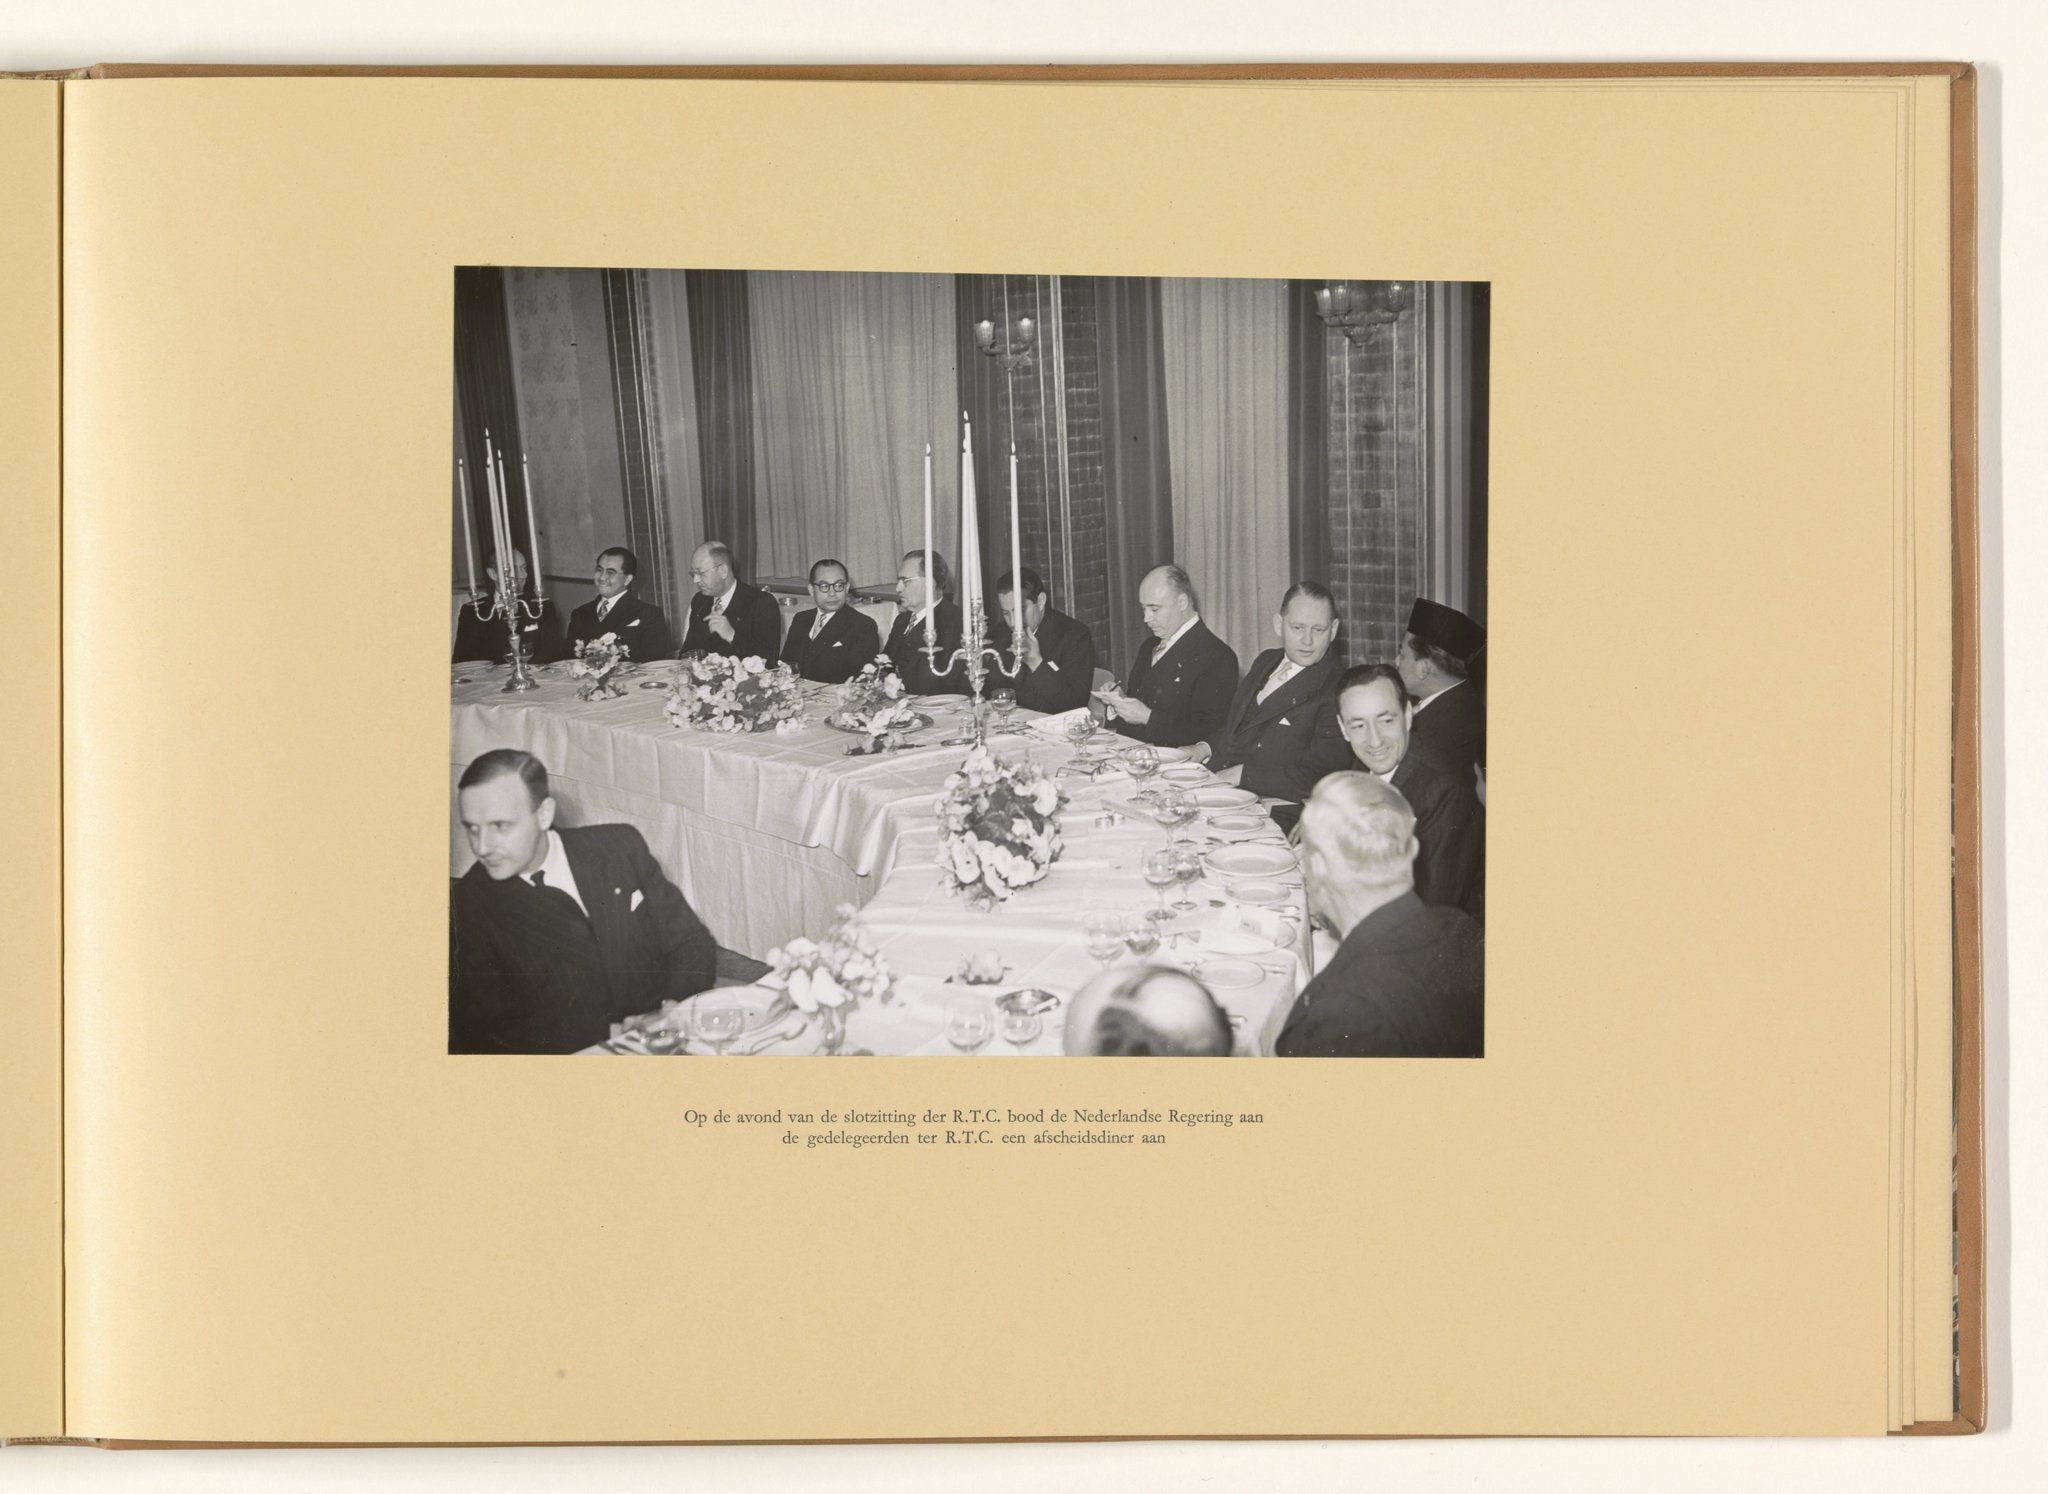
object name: photograph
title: Op de avond van de slotzitting der R.T.C. bood de Nederlandse Regering aan de gedelegeerden der R.T.C. een afscheidsdiner aan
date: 1949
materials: paper, photographic support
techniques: gelatin silver print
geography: the hague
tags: mohammad hatta, utrecht, willem drees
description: Afscheidsdiner aan de gedelegeerden op de slotdag van de rondetafelconferentie op 2 november 1949. Links minister Van Maarseveen, premier Hatta, premier Drees en sultan Hamid II. Foto in het fotoalbum met 37 foto's van de rondetafelconferentie gehouden tussen 23 augustus en 2 november in Den Haag in 1949 tussen vertegenwoordigers van Nederland, de Republiek Indonesië en de Bijeenkomst Federaal Overleg. Het exemplaar aangeboden aan premier Willem Drees.